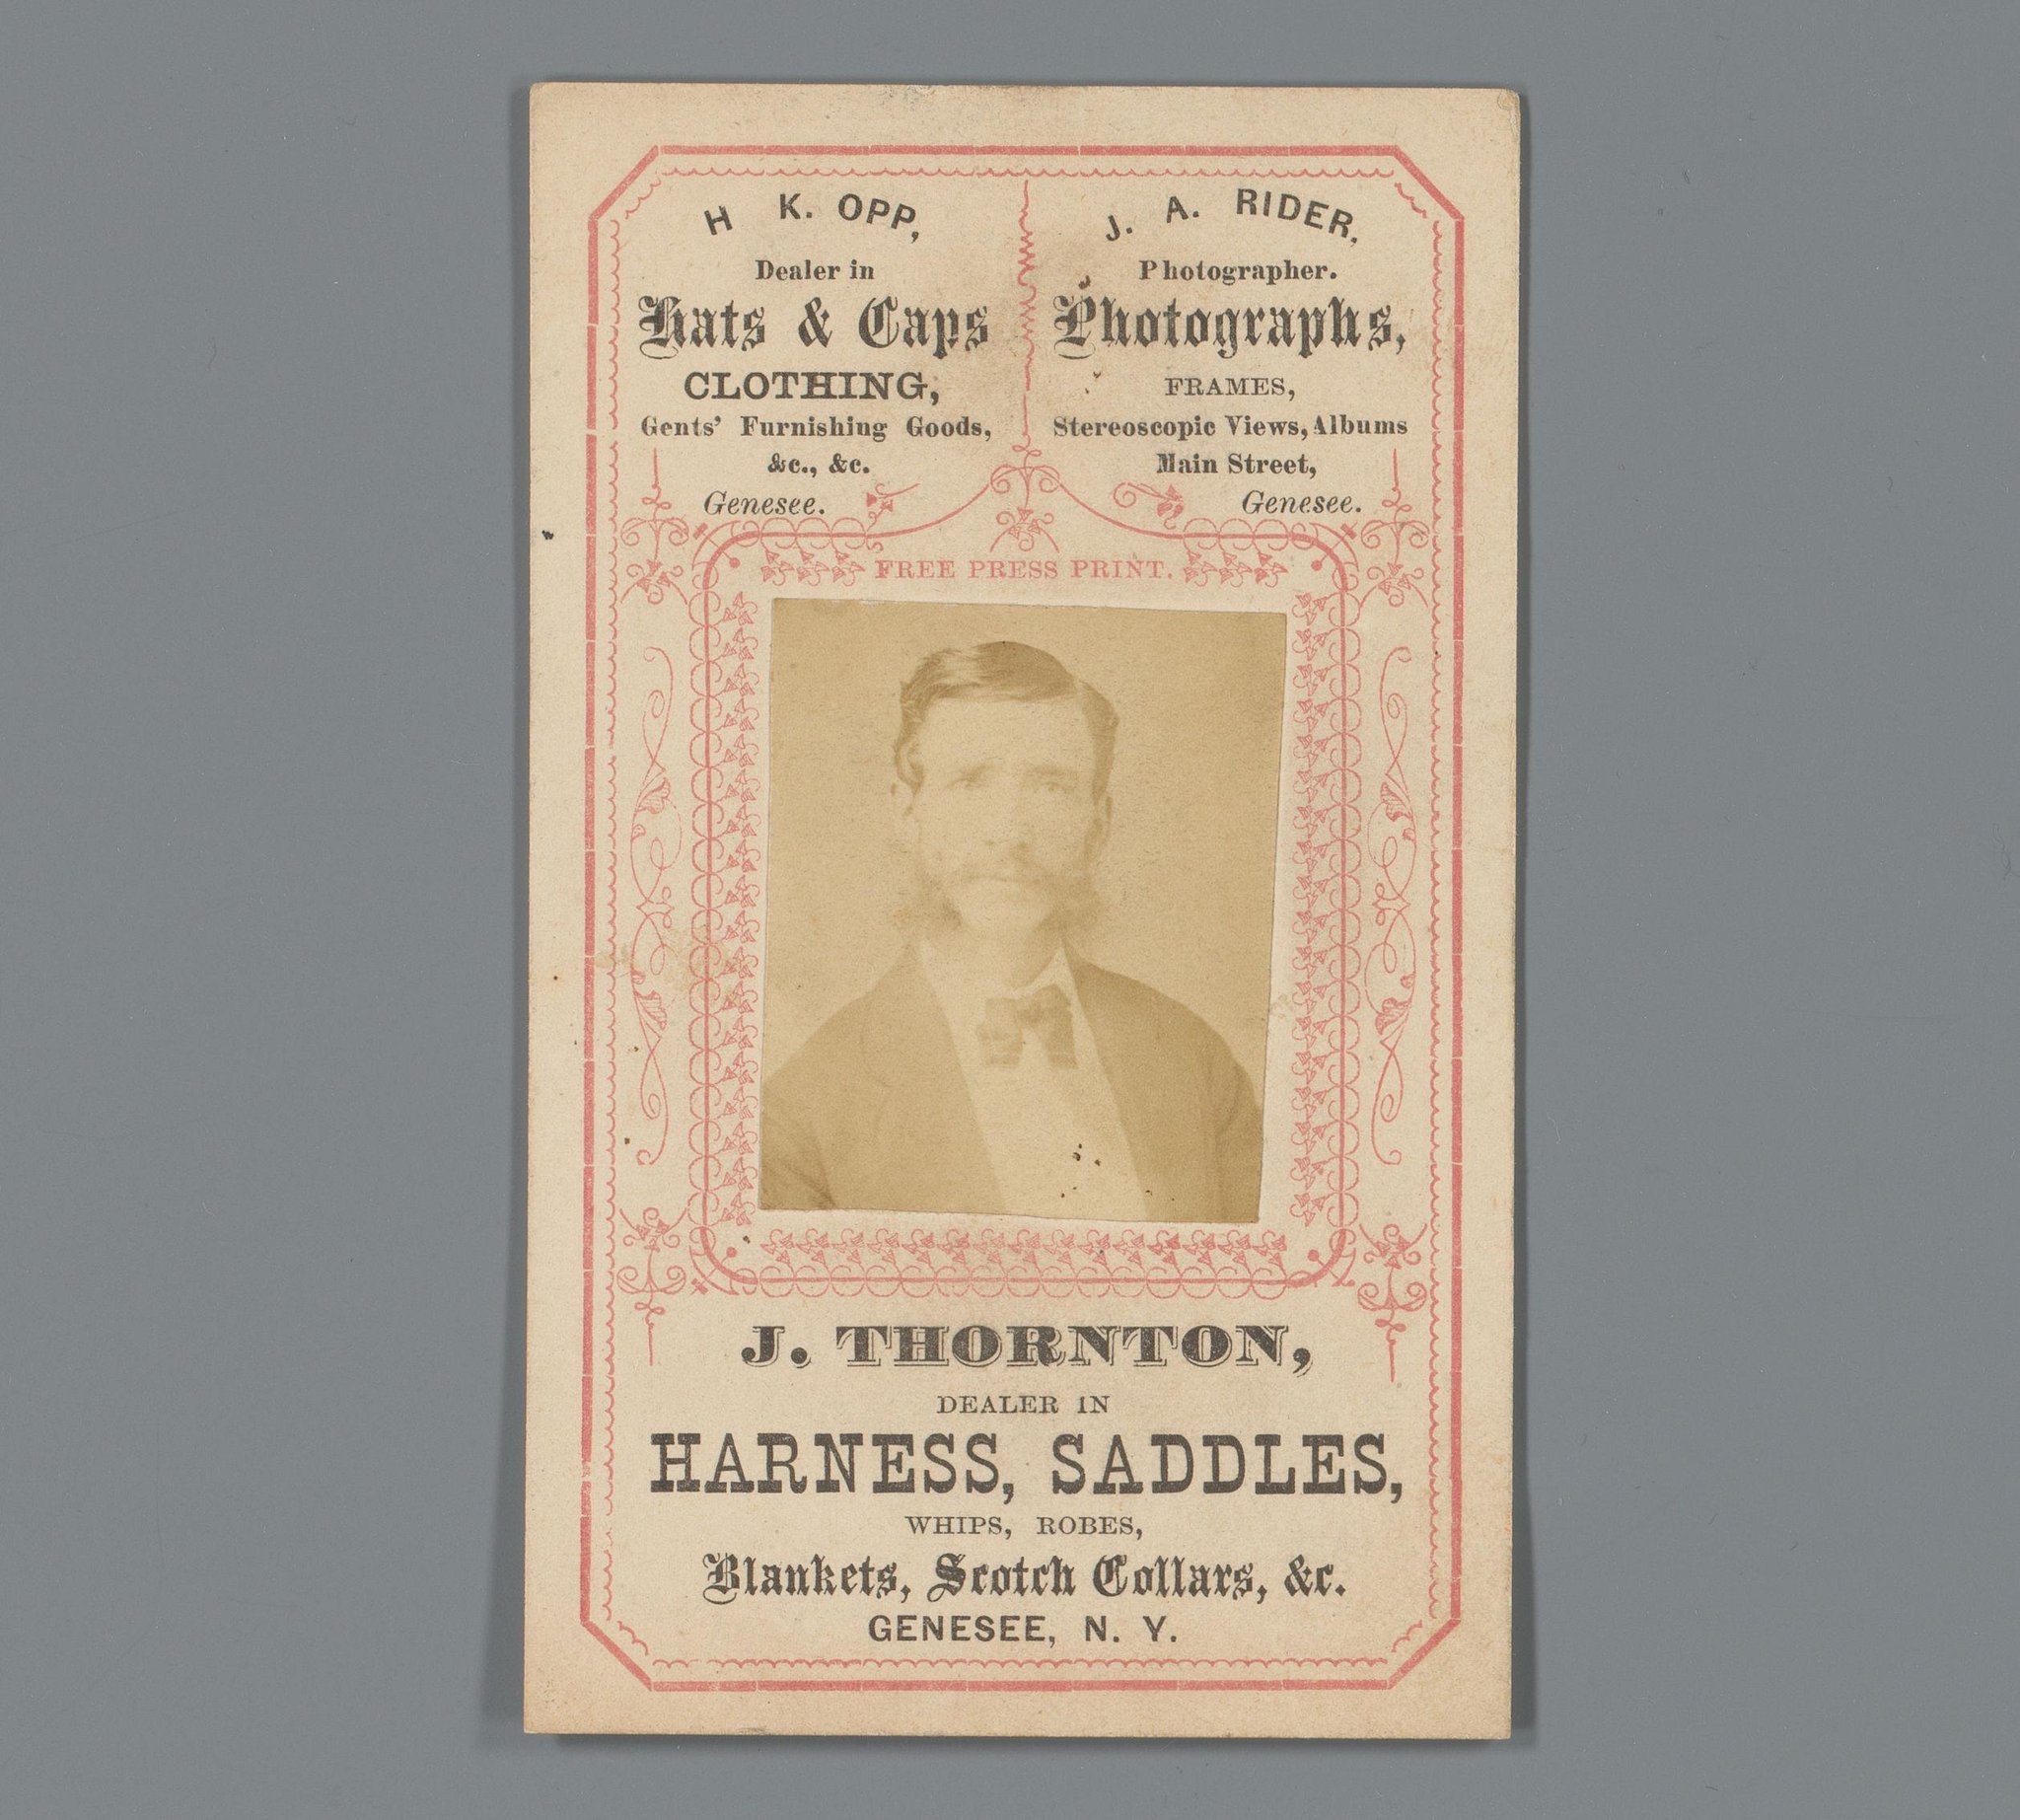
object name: photograph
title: Reclame voor verschillende zaken in Genesee, New York, met portret van een man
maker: j.a. rider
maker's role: fotograaf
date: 1850-1915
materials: cardboard, photographic support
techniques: albumen print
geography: new york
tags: advertising, historical persons not known by name, new york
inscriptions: inscription: ‘(...)/ J.A. RIDER,/ Photographer./ Photographs,/ FRAMES,/ Stereoscopic Views, Albums/ Main Street,/ Genesee./ (...)’